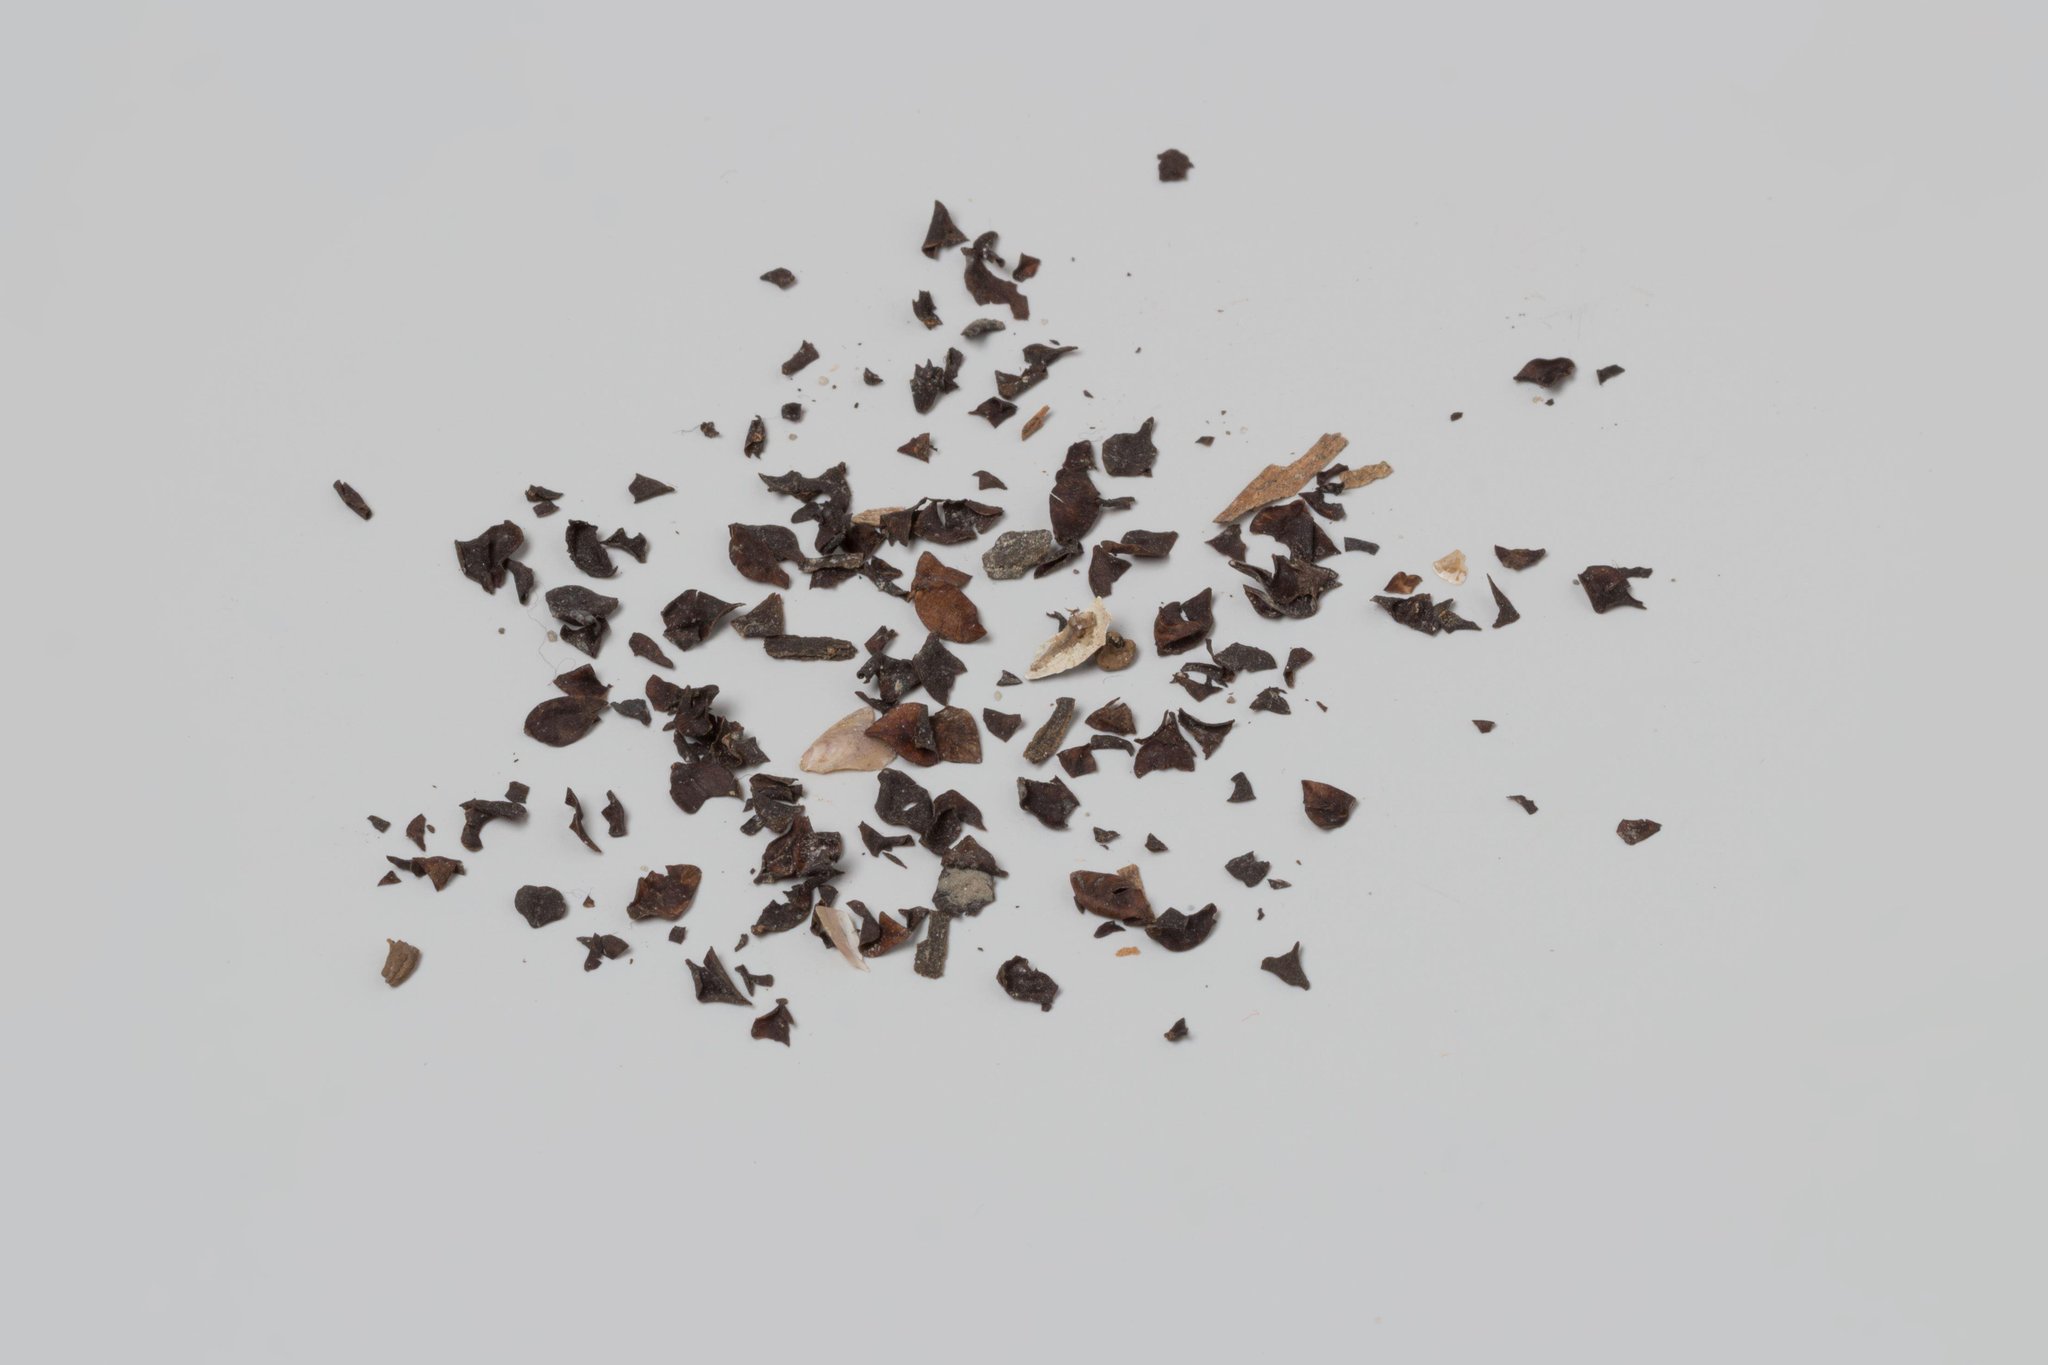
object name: zemelen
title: Monster van (graan-) zemelen en boekwijtkaf uit het wrak van de in 1735 vergane Oost-Indiëvaarder 't Vliegend Hart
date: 1700-1735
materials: organic material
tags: 't vliegend hart (schip), verenigde oostindische compagnie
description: Het gaat hierbij om een organisch monster. Zemelen zijn de buitenste lagen, dus de vliezen van een graankorrel. Zemelen ontstaan bij het malen van graan, daarbij worden ze afgescheiden van de korrel. Boekweitkaf werd gebruikt als verpakkingsmateriaal, vooral voor het verpakken van kleipijpen. Chaff of buckwheat.